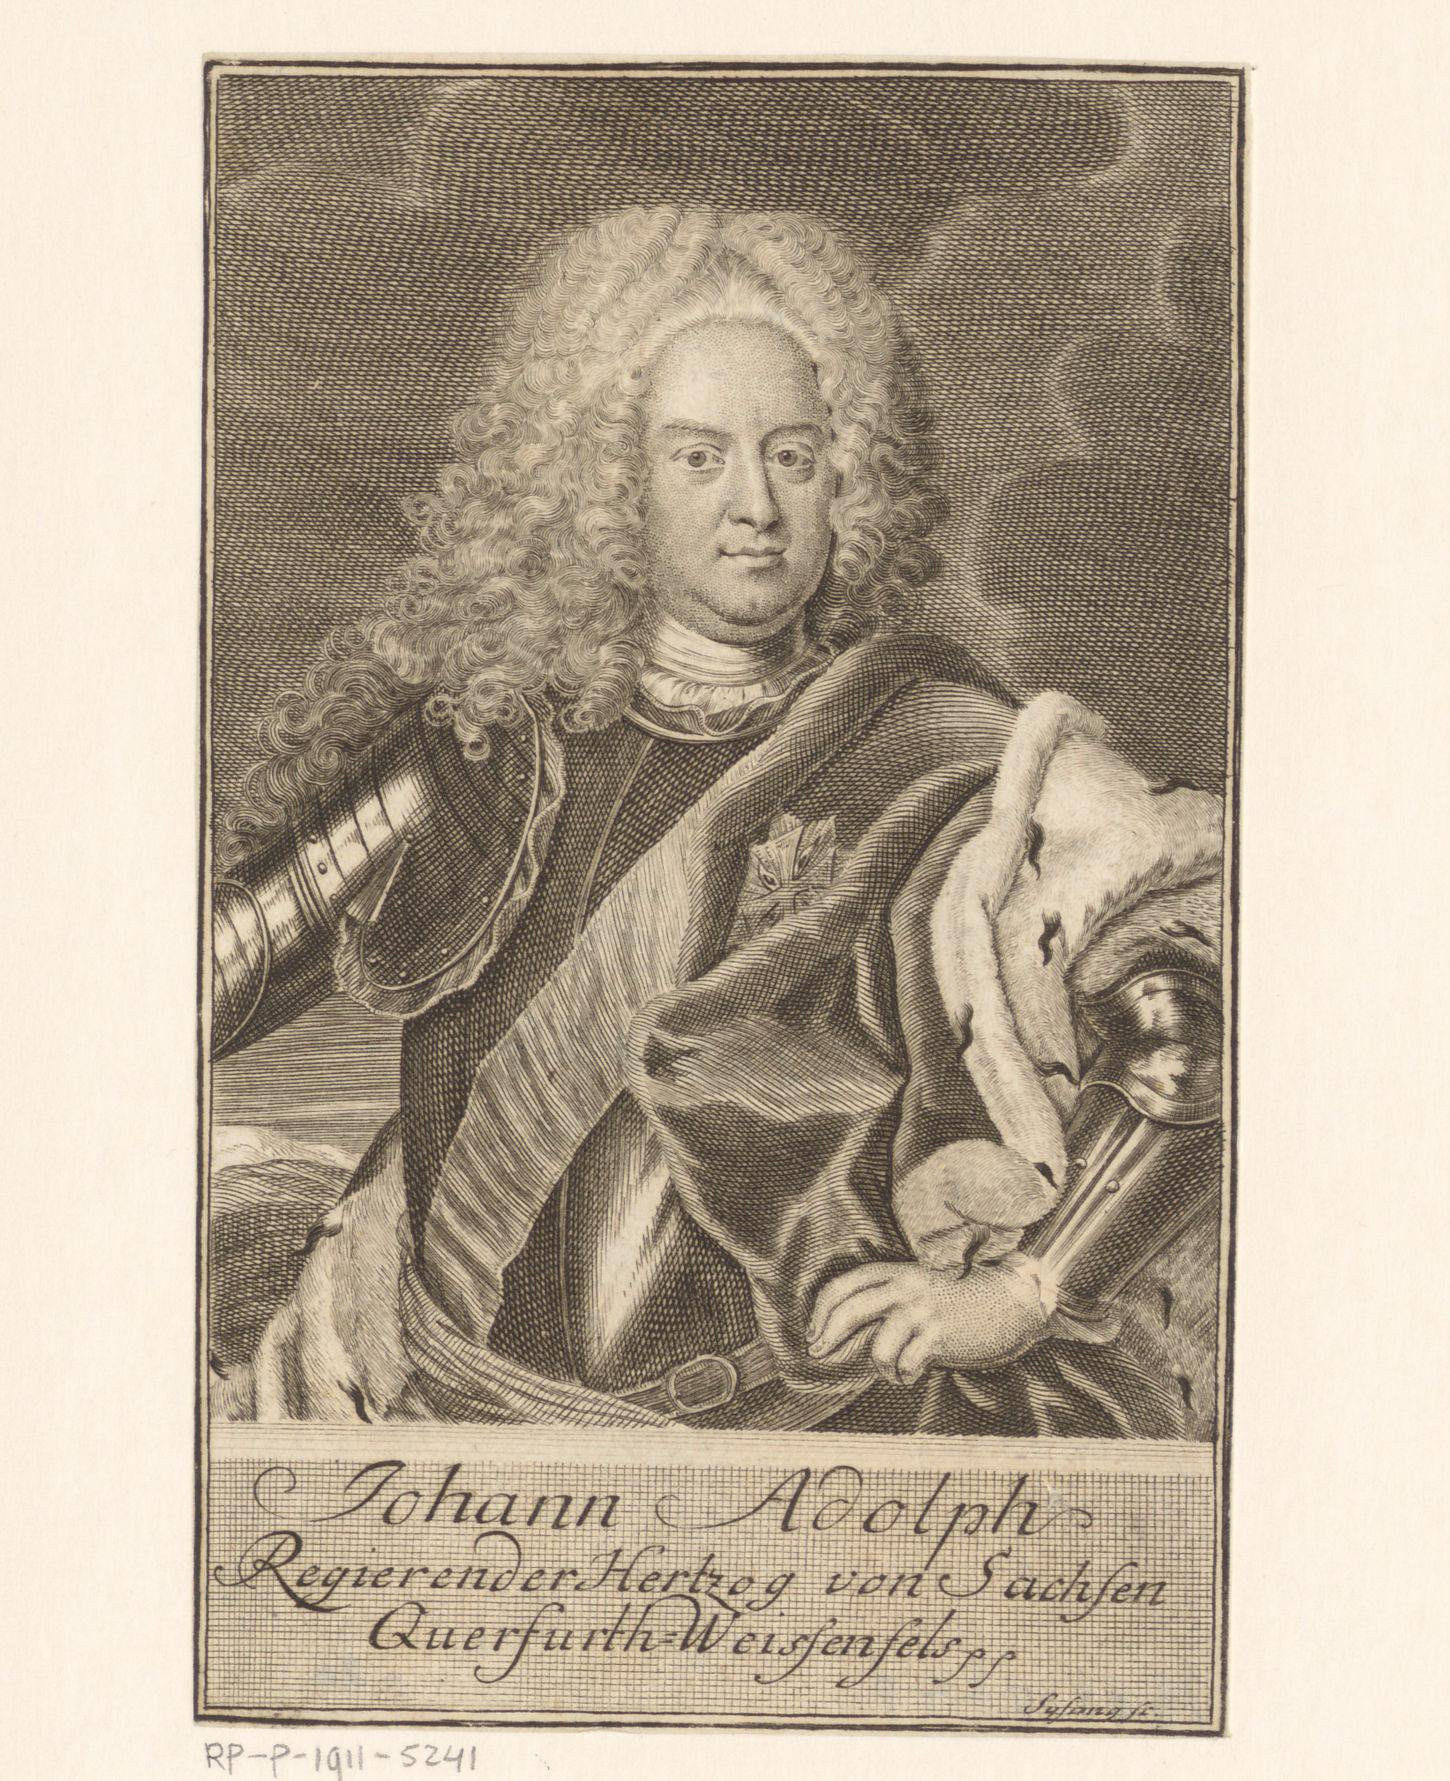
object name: print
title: Portret van Johann Adolph II von Sachsen-Weißenfels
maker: johann christoph sysang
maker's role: print maker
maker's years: 1703-1757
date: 1736-1757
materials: paper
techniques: engraving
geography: leipzig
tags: armour, historical persons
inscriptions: collector's mark: Lugt 2228